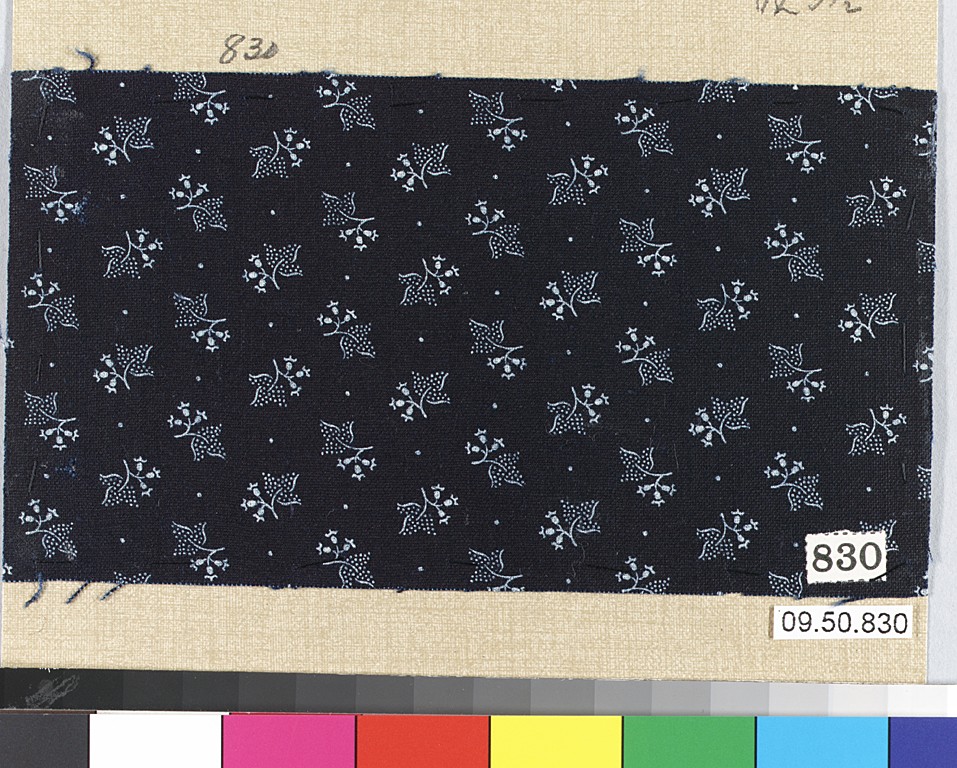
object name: piece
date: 1801-1900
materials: cotton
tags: leaves